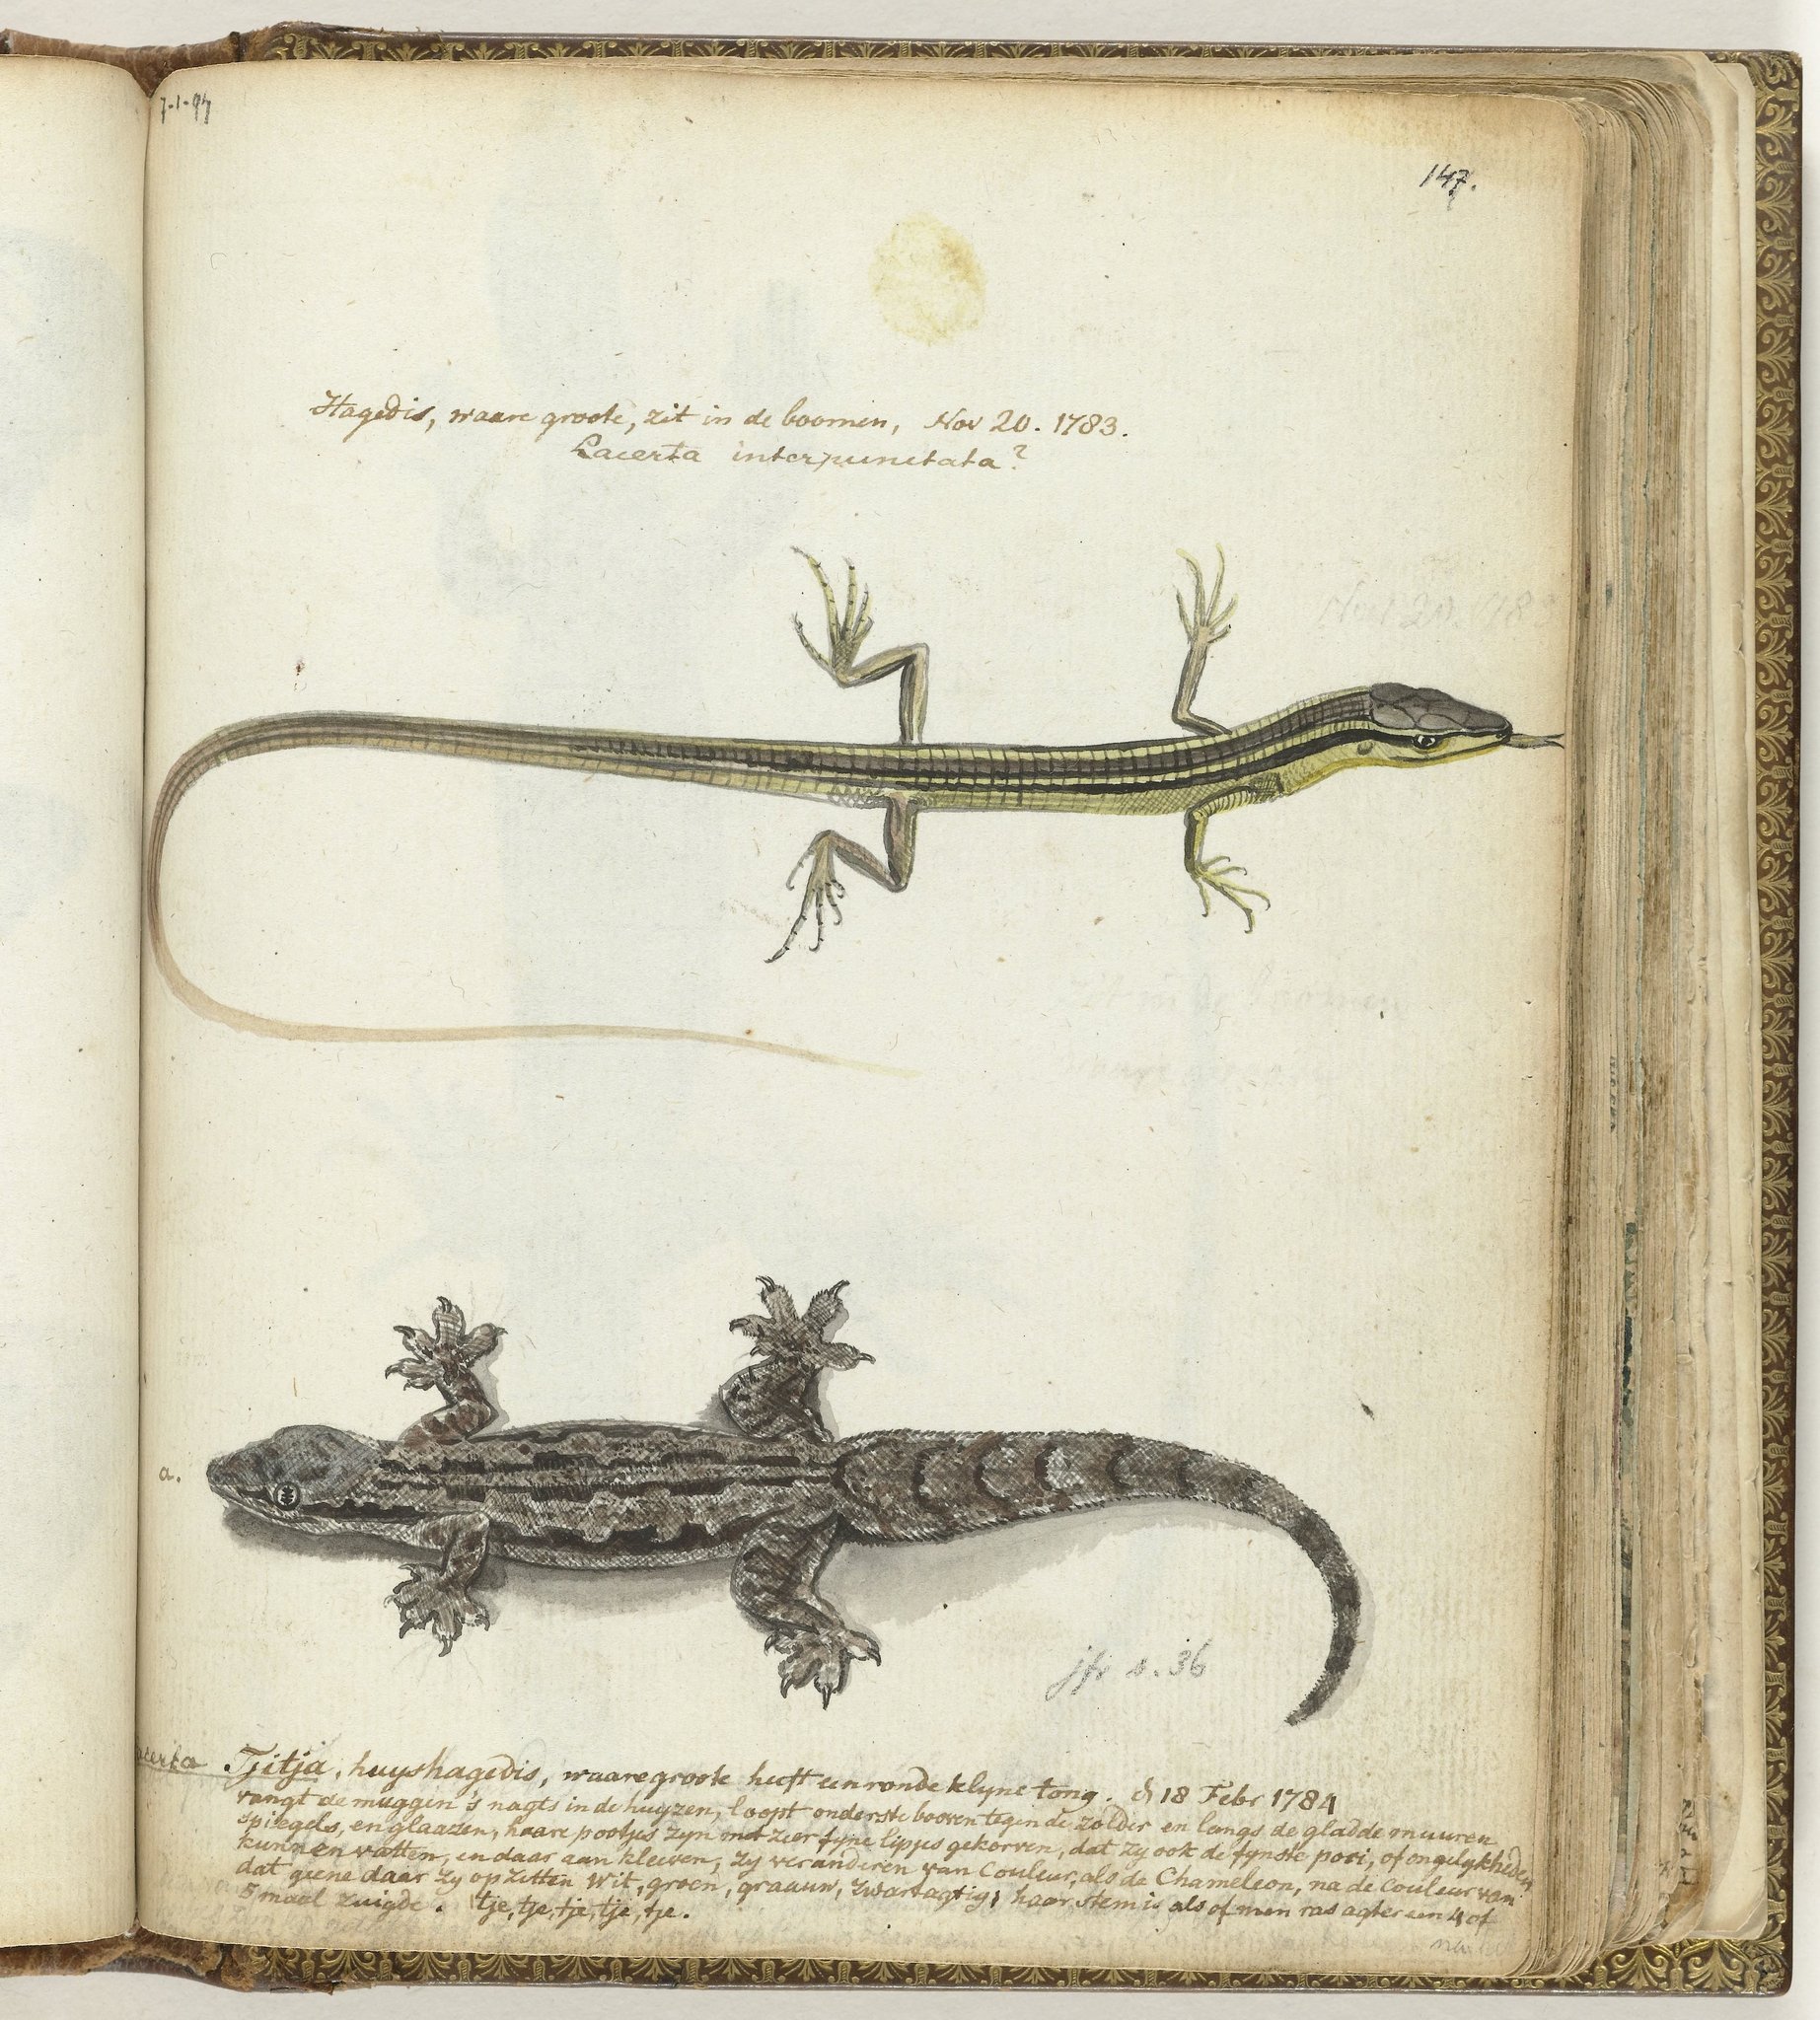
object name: drawing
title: Hagedis en tjitjak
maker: jan brandes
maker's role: draughtsman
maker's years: 1743-1808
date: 1783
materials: paper, pencil, watercolor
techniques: brush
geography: jakarta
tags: lizards: lizard, indonesia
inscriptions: inscription: ‘Lacerta Tjitja, huyshagedis, waare groote heeft een ronde klyne tong. d. 18 Febr 1784 vangt de muggen 's nagts in de huyzen, loopt onderste booven tegen de zolder en langs de gladde muuren spiegels, en glaazen, haare pootjes zyn met zeer fyne lipjes gekorven, dat zy ook de fynste pori, of ongelykheden kunnen vatten, en daar aan kleeven, zy veranderen van couleur, als de Chameleon, na de couleur van dat geene daar zy opzitten wit, groen, graauw, zwartgagtig, haar stem is als of men ras agter een 4 of 5 maal zuigde. tje, tje, tje, tje, tje.’, inscription: ‘Hagedis, waare groote, zit in de boomen, Nov 20. 1783. Lacerta interpunetata?’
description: Kleurtekening van een hagedis en een tjitjak of huisgekko op ware grootte, gezien schuin van boven. Met opschrift. Onderdeel uit het schetsboek van Jan Brandes, dl. 1 (1808), p. 147 en zie ook, p. 36.